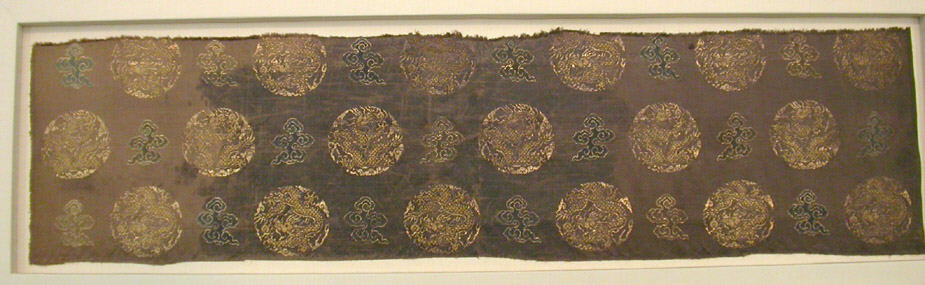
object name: piece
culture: chinese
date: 1701-1733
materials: metal thread, silk